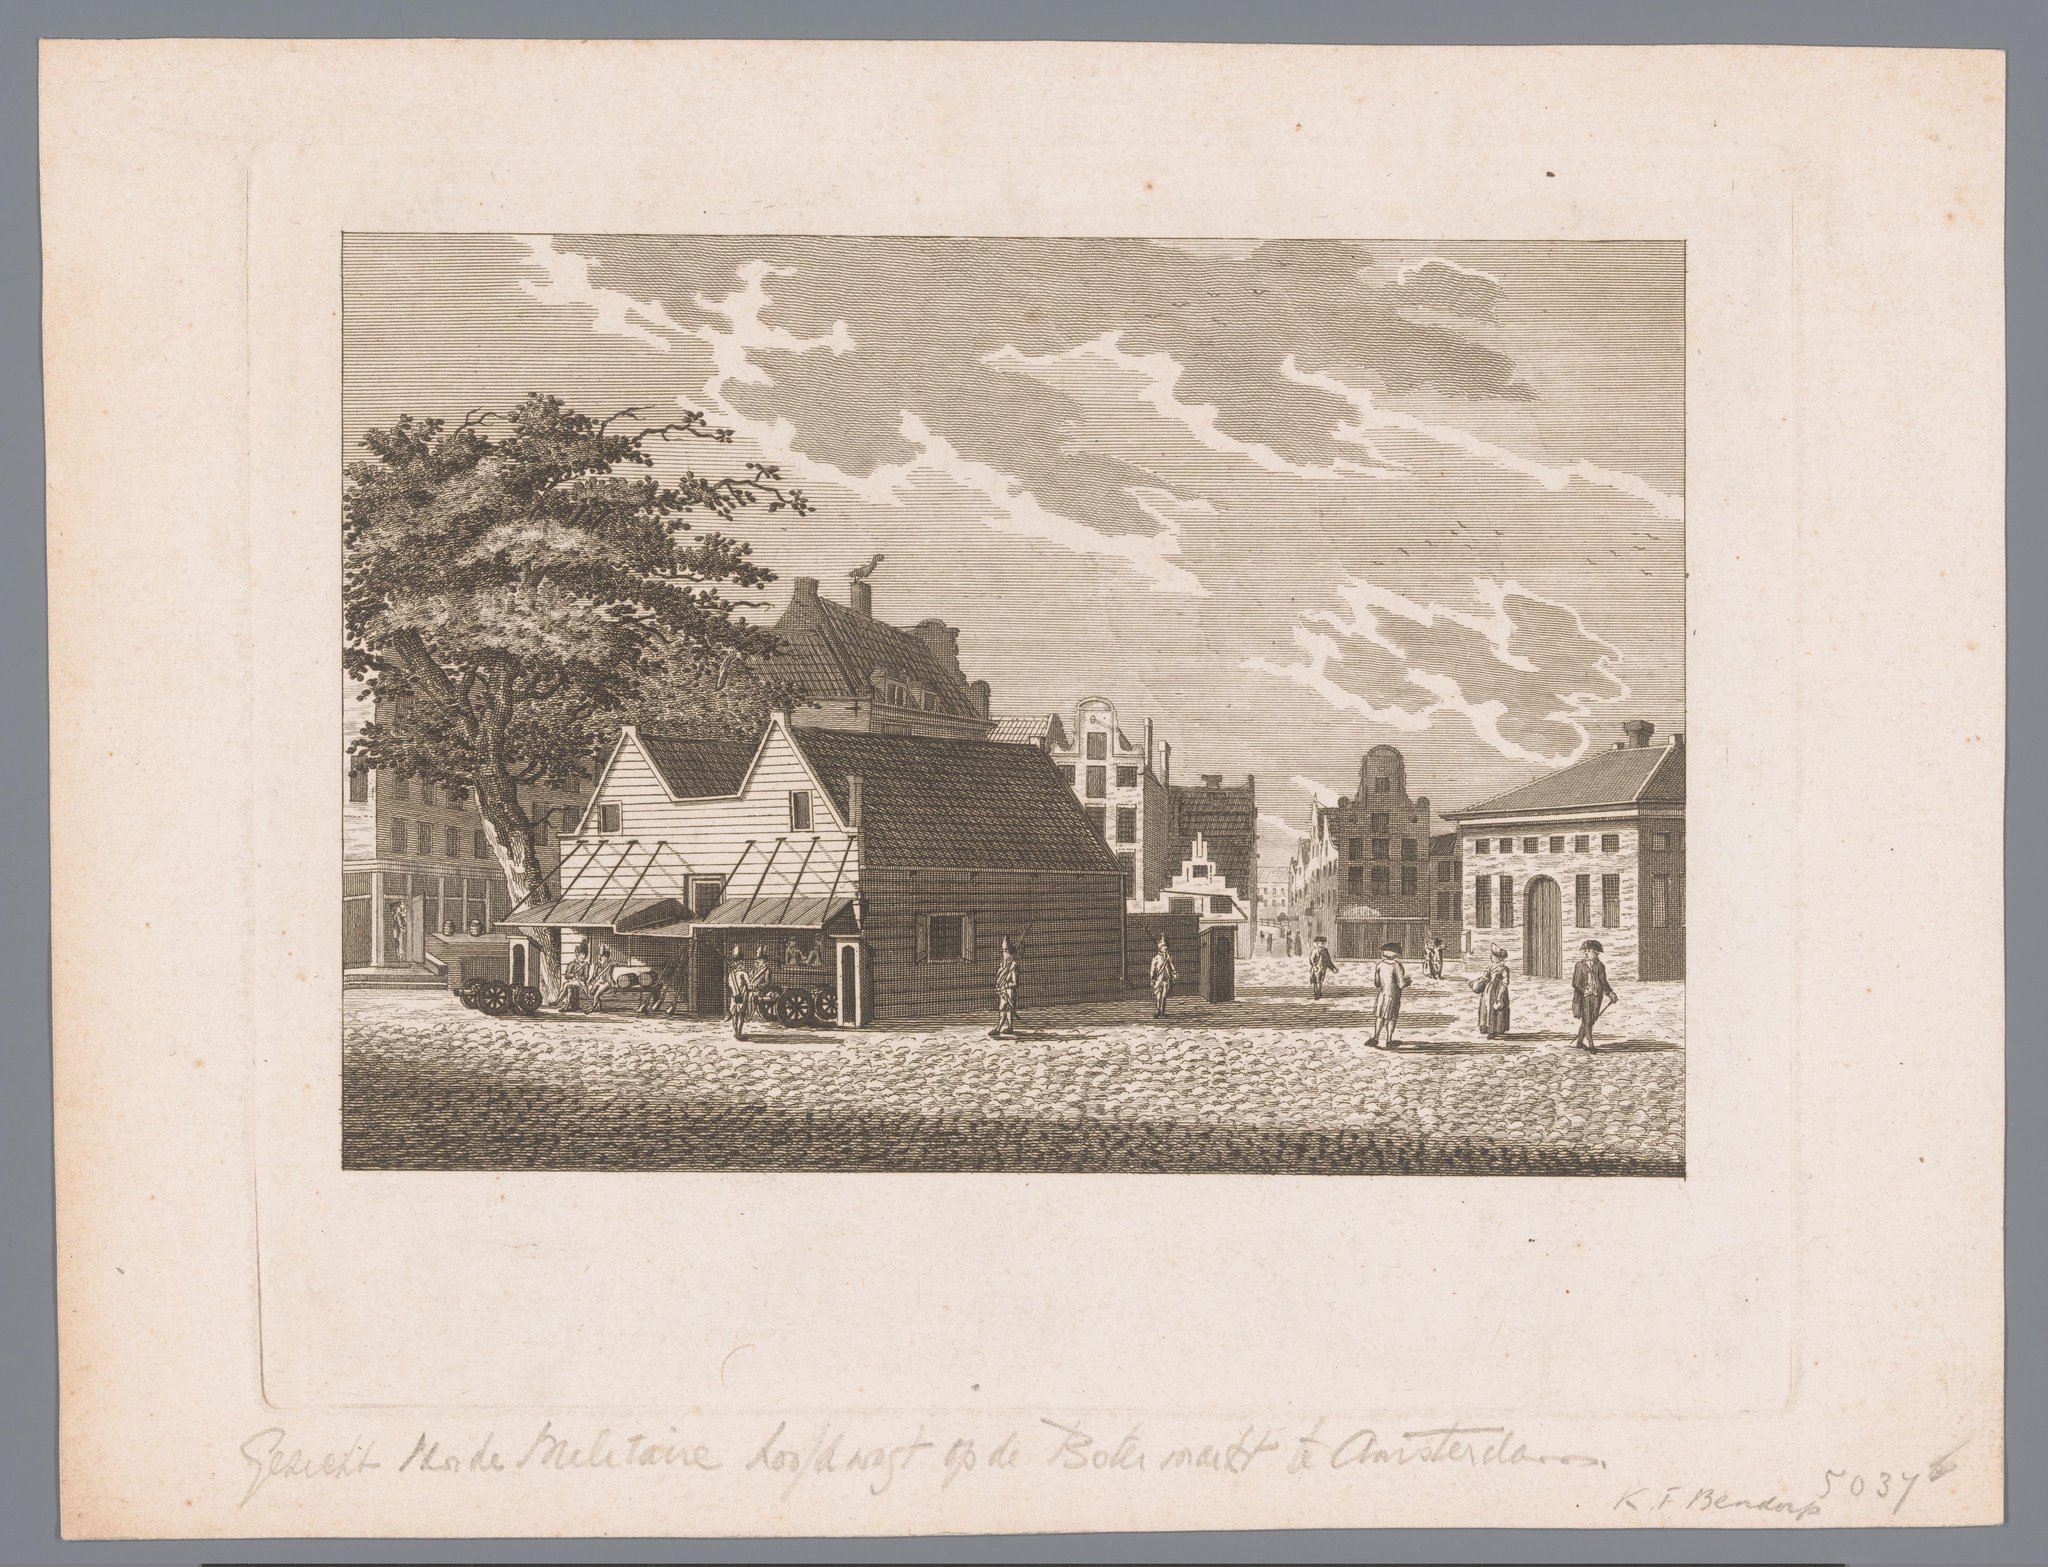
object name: print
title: Hoofdwacht van de landsmilitie op de Botermarkt in Amsterdam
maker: jacobus wijsman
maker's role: print maker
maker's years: 1768-1827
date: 1788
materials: paper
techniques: engraving, etching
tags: barracks (+ land forces), guard duty, keeping sentry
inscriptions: collector's mark: Lugt 2228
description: Gezicht op de hoofdwacht van de landsmilitie op het huidige Rembrandtplein.